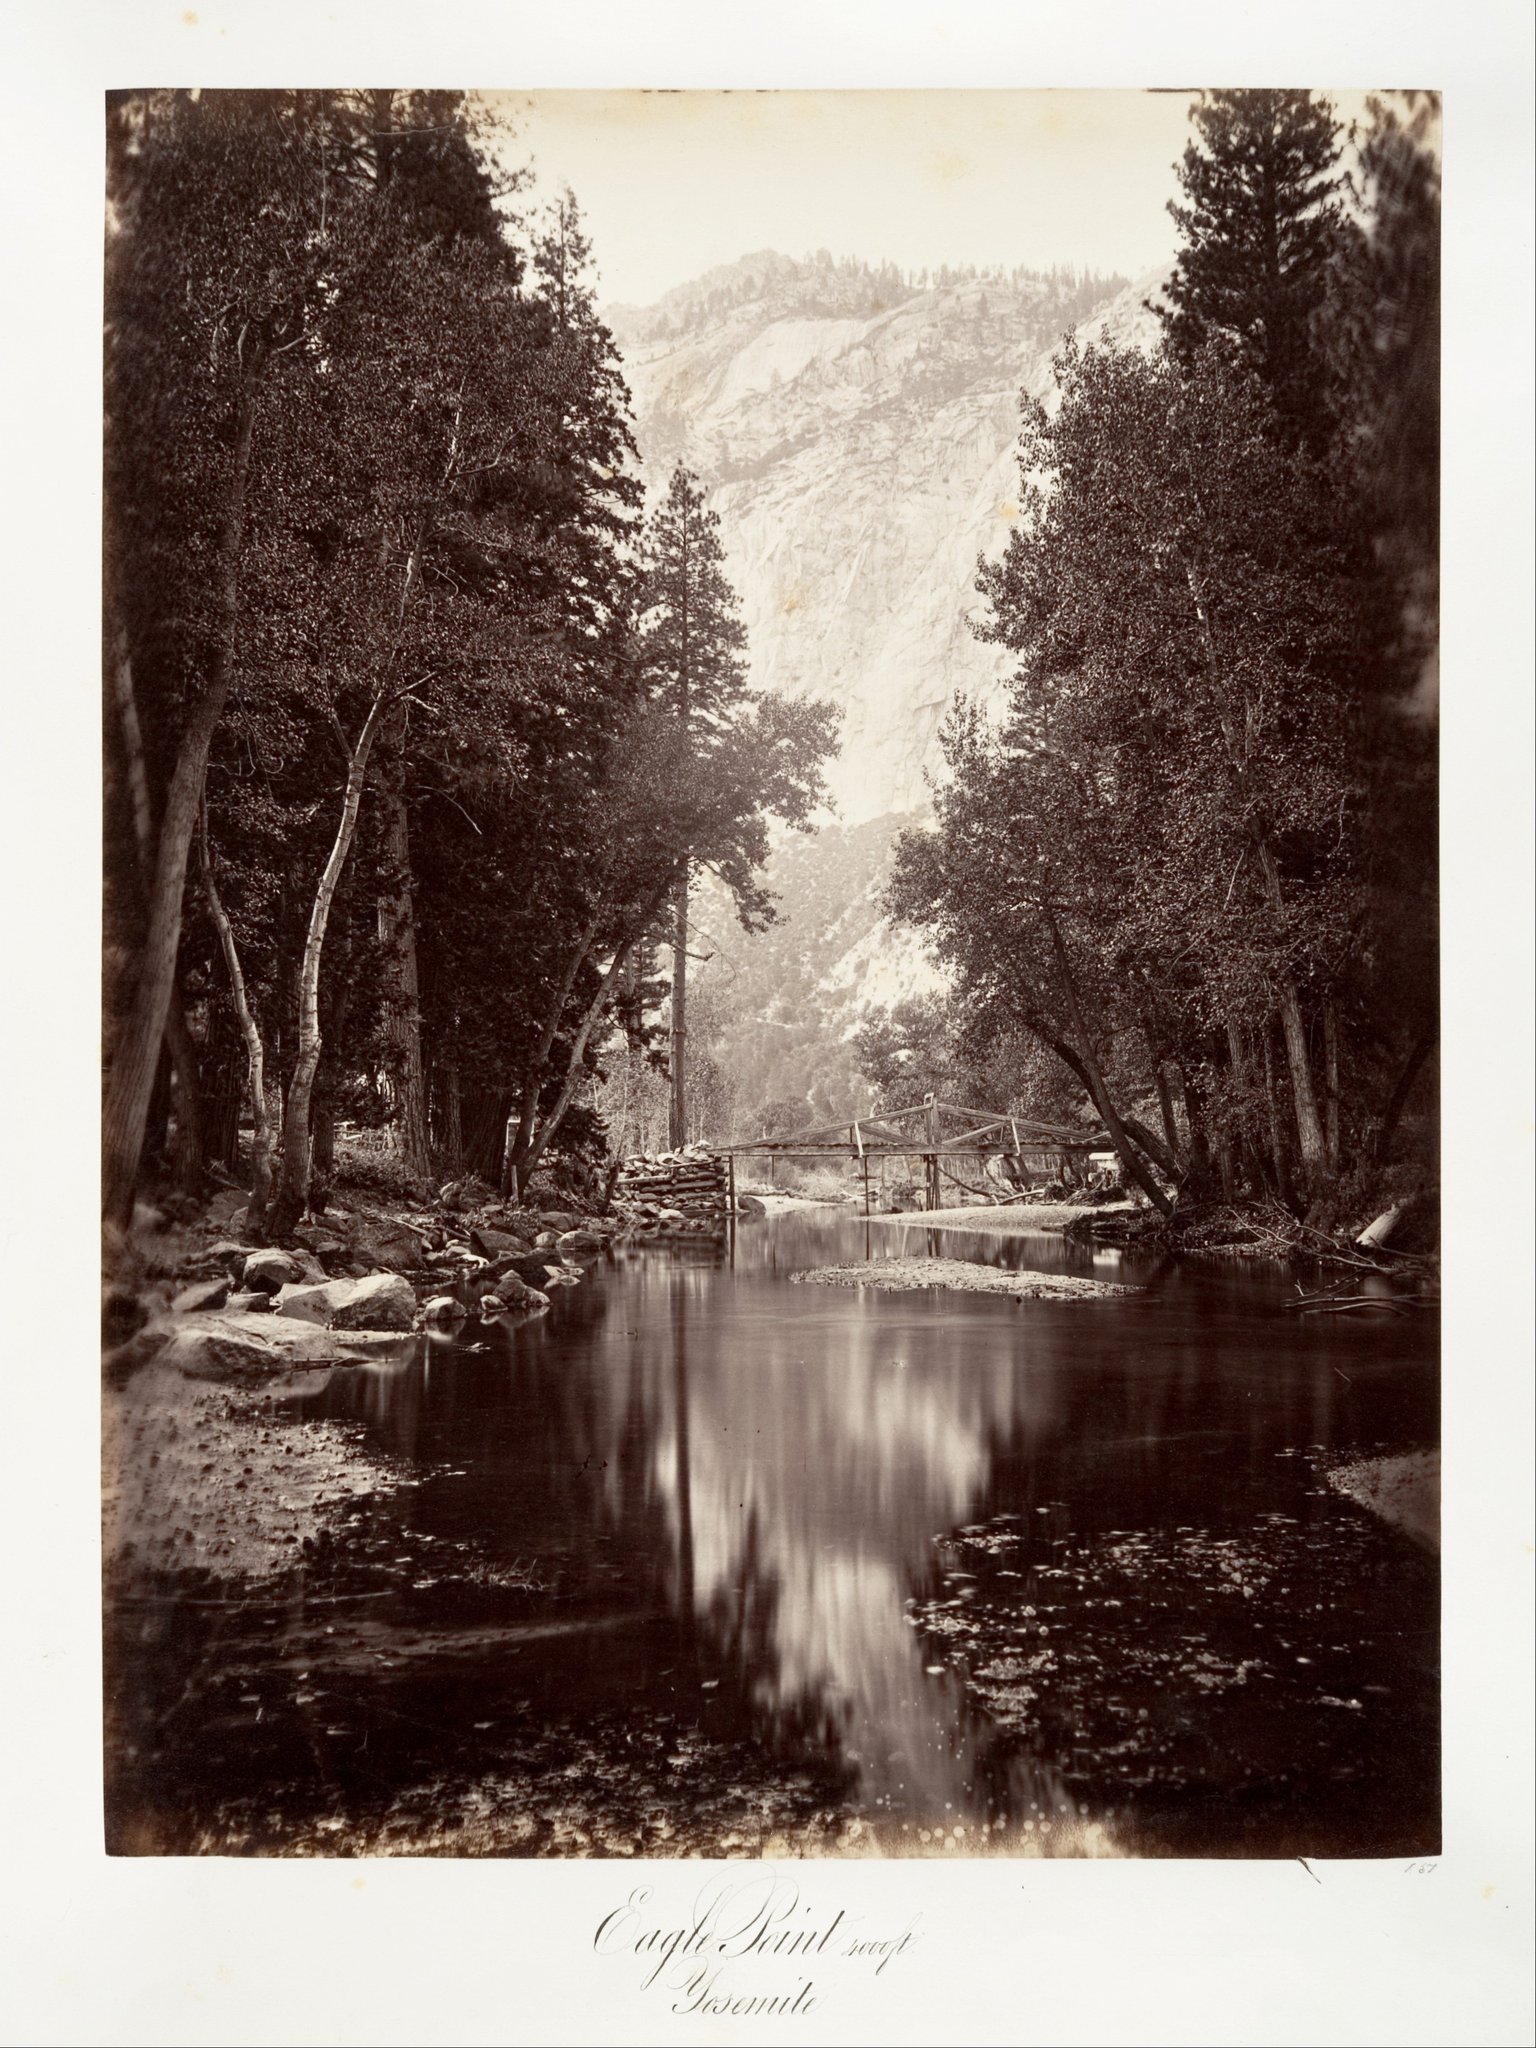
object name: photograph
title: Eagle Point, 4,000 feet, Yosemite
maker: carleton e. watkins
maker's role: artist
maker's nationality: american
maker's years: 1829-1916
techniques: albumen silver print, glass negative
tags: mountains,landscapes